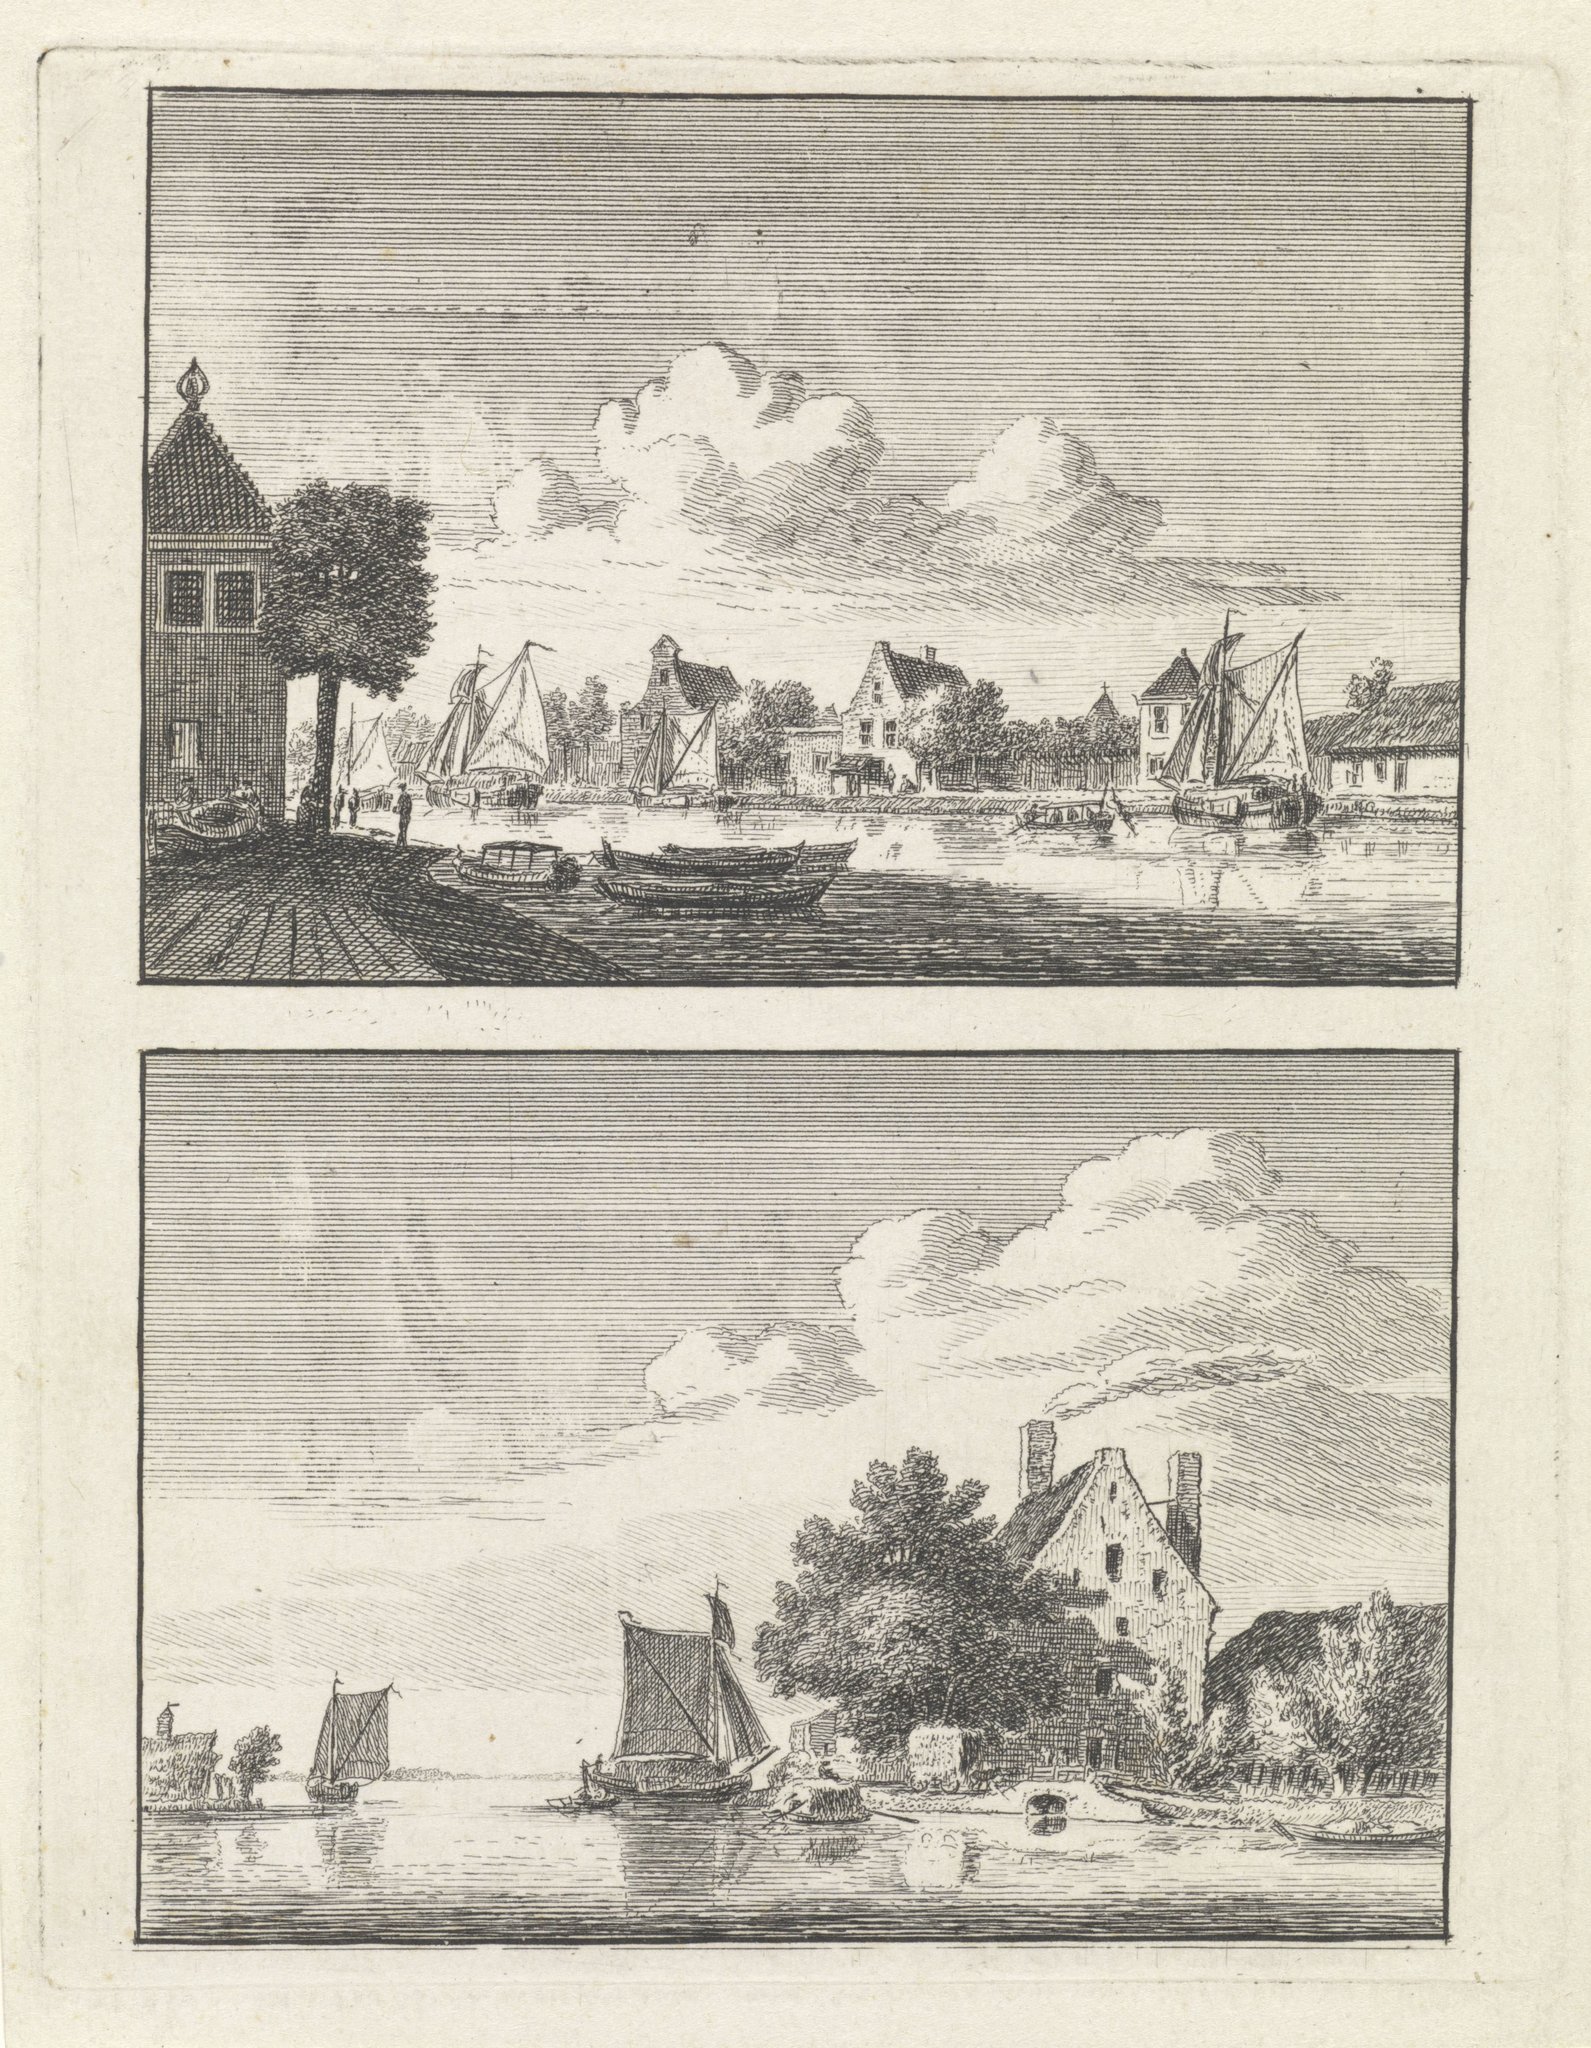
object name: print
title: Twee rivierlandschappen met zeilschepen bij huizen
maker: hendrik spilman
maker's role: draughtsman, painter, print maker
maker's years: 1721-1784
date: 1742-1784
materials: paper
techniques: etching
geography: haarlem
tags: sailing-ship, sailing-boat, river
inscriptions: collector's mark: Lugt 240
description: Twee afbeeldingen op een blad: boven een rivierlandschap met boten en huizen. Onder een rivierlandschap met een zeilschip bij een huis.